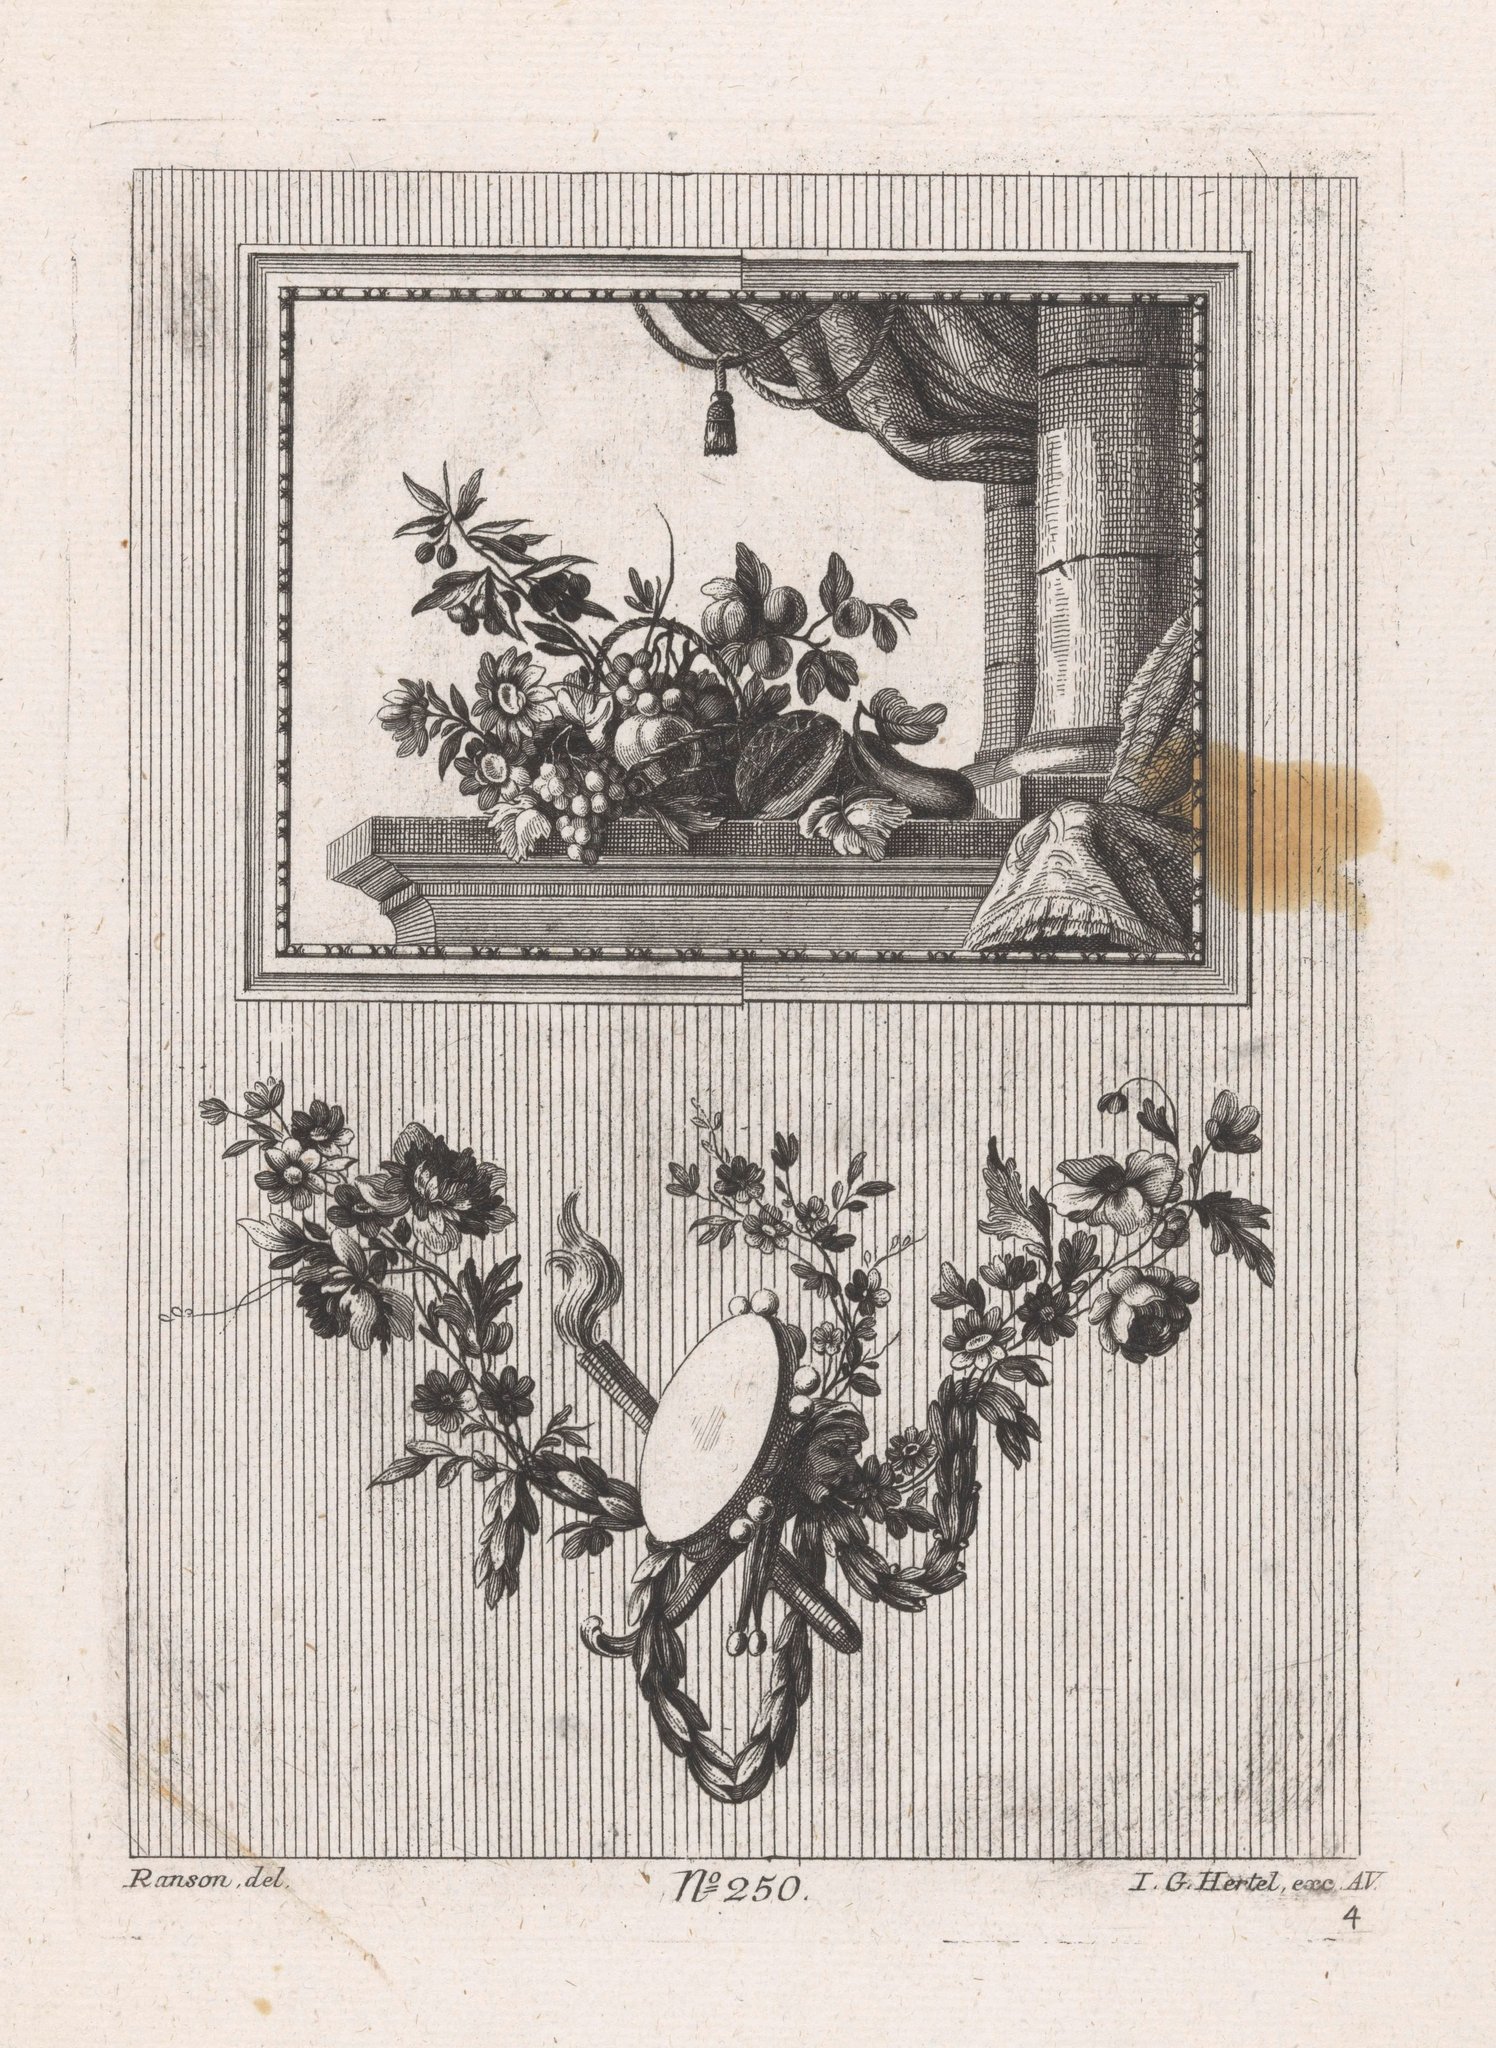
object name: ornament print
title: Paneel met fruit en guirlande met tamboerijn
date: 1746-1775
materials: paper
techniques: etching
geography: augsburg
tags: tambourine, ornament ~ festoon, garland, fruits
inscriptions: collector's mark: Lugt 2228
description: Een rechthoekig met een mand met fruit en bloemen, rechts draperieën en zuilen. Daaronder een guirlande met een fakkel en een tamboerijn. Uitgeversnummer 250.